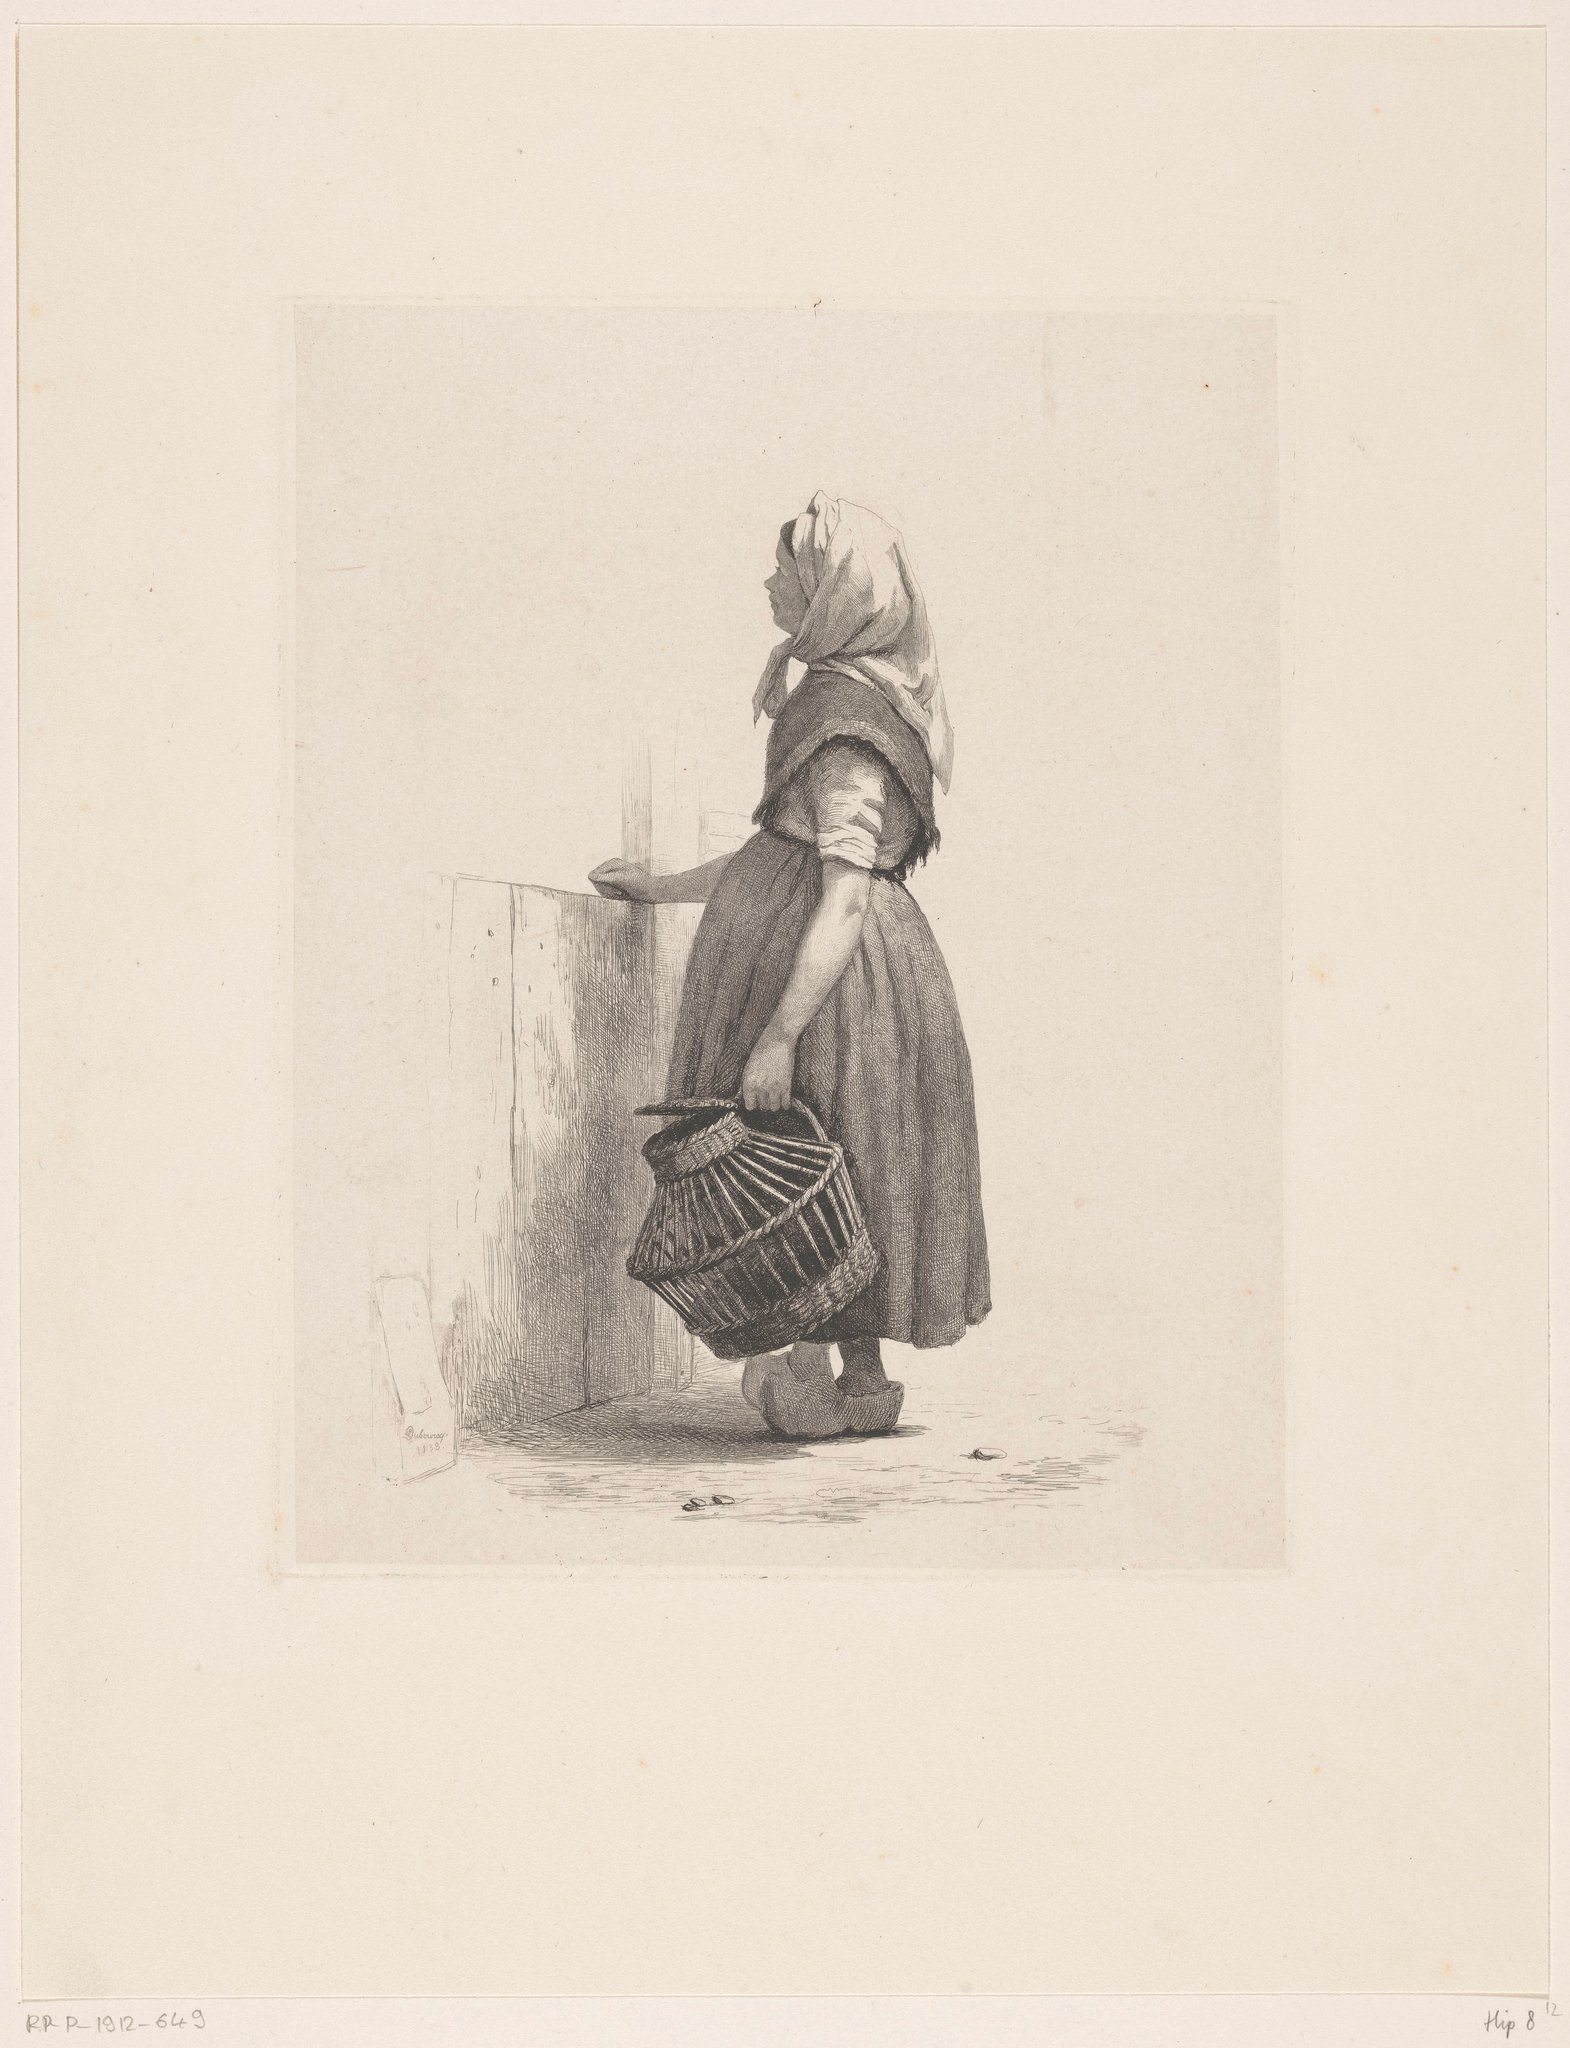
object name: print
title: Staand meisje met pluimveemand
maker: pierre louis dubourcq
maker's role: draughtsman, painter, print maker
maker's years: 1815-1873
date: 1838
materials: paper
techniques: drypoint, etching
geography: netherlands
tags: fowl (cock, hen, chicken, etc.) (+ animal cage)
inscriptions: collector's mark: Lugt 2228